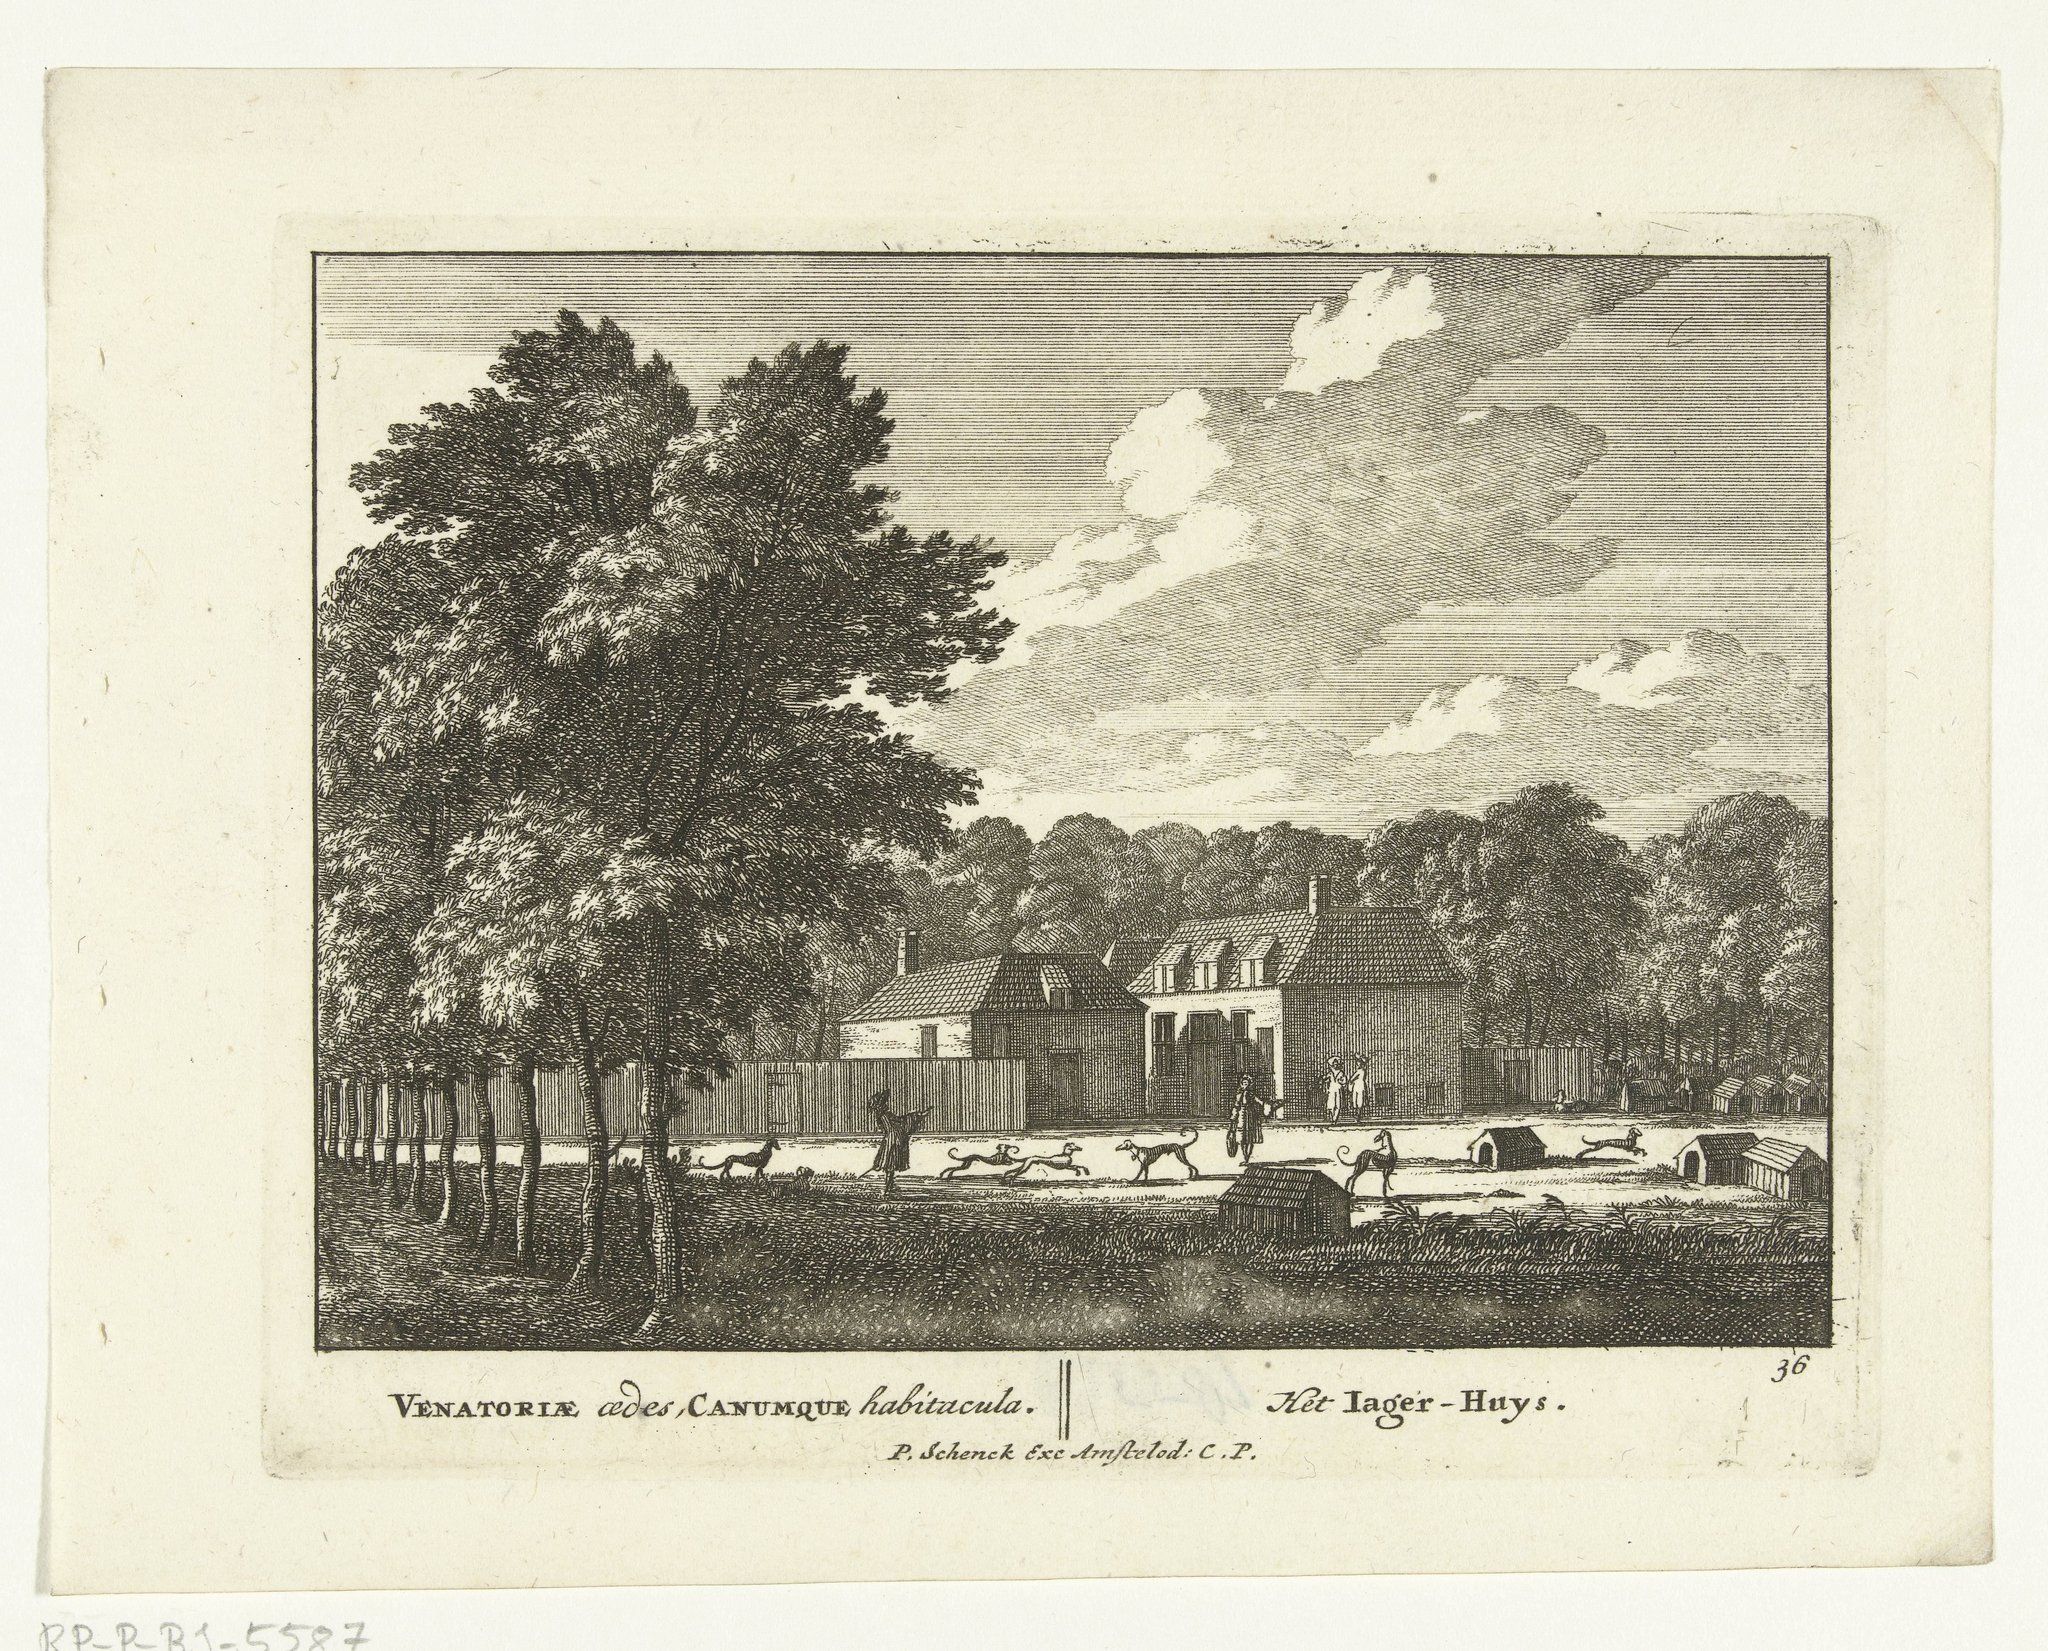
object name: print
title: Admirandorum quadruplex spectaculum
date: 1695-1705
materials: paper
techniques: etching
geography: amsterdam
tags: training of hunting dog, man and animal (+ stable, shed, kennel), hunting-seat, hunting lodge, 'rendez-vous de chasse', 'jagdschloss'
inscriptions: collector's mark: Lugt 2228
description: Gezicht op het jachthuis van Het Loo, met op de voorgrond hondenhokken en rennende windhonden. Prent uit een serie van 71 prenten met Rijnlandschappen, gezichten op vorstelijke paleizen en stadsgezichten uit Den Haag en Amsterdam.